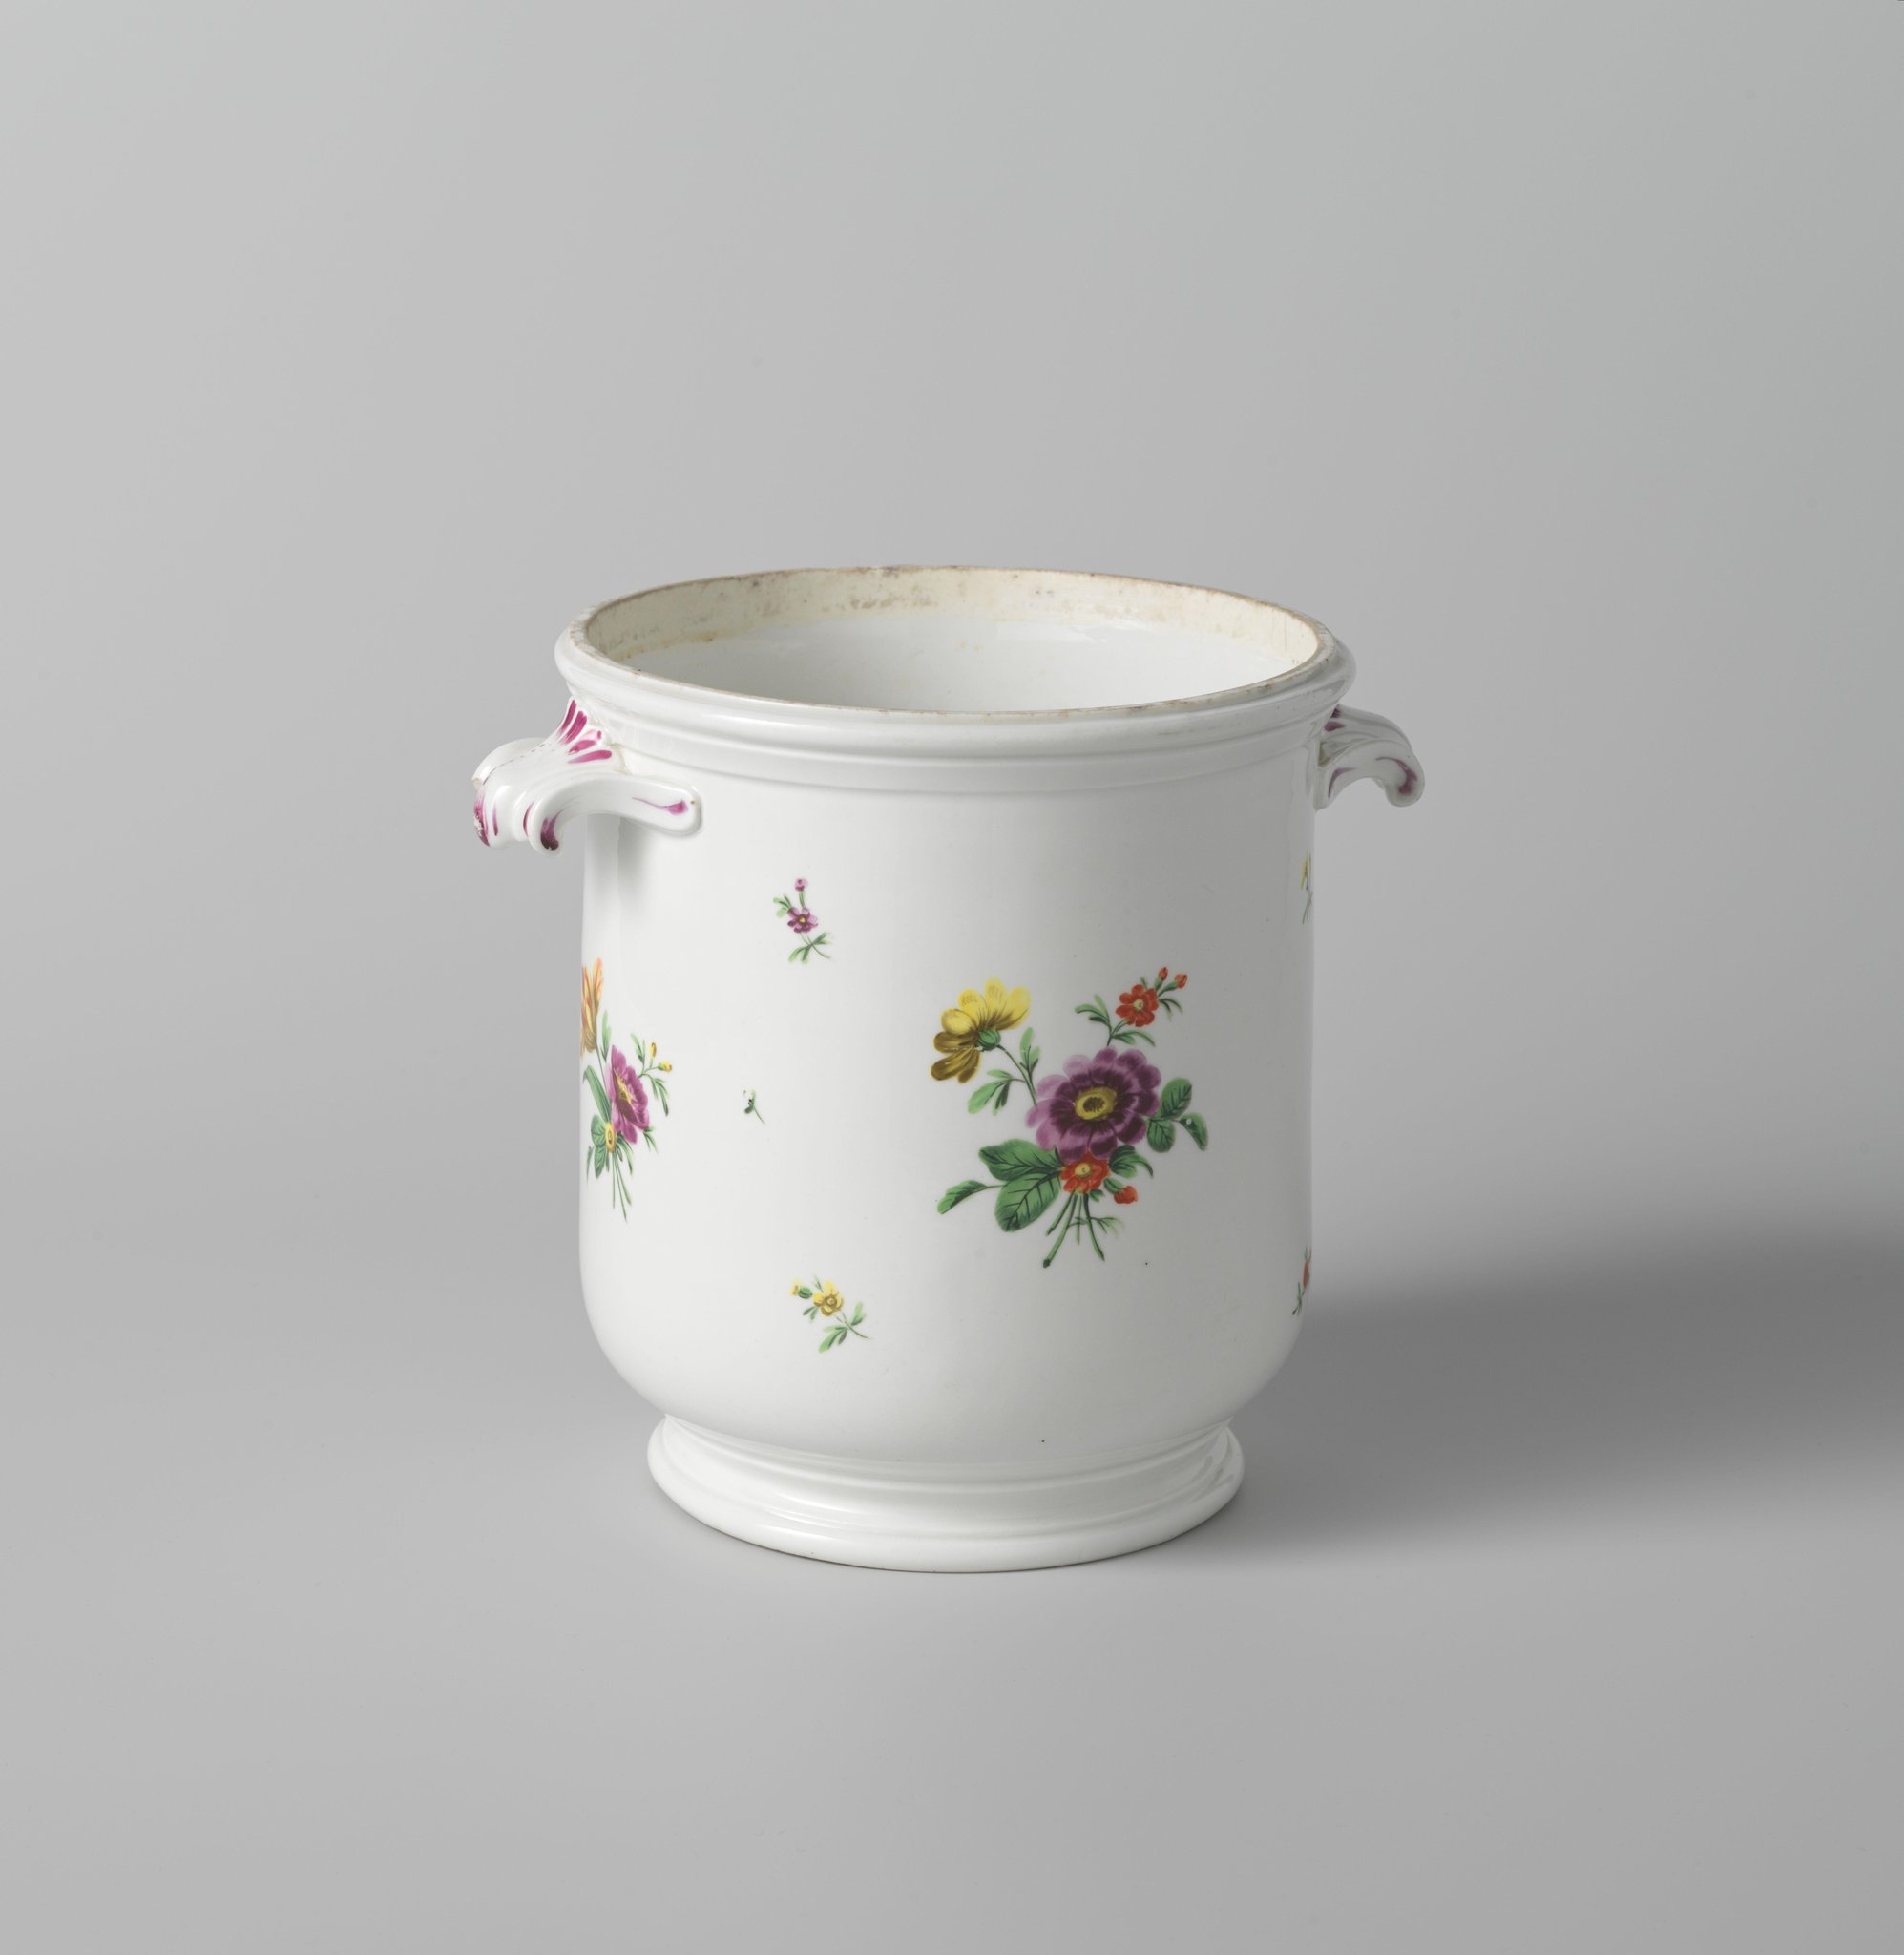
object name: service set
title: Jardiniere with bouquets and flower sprays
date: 1800-1849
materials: glaze, paint, porcelain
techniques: firing, forming, turning, vitrification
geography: vienna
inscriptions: mark: ‘schild’